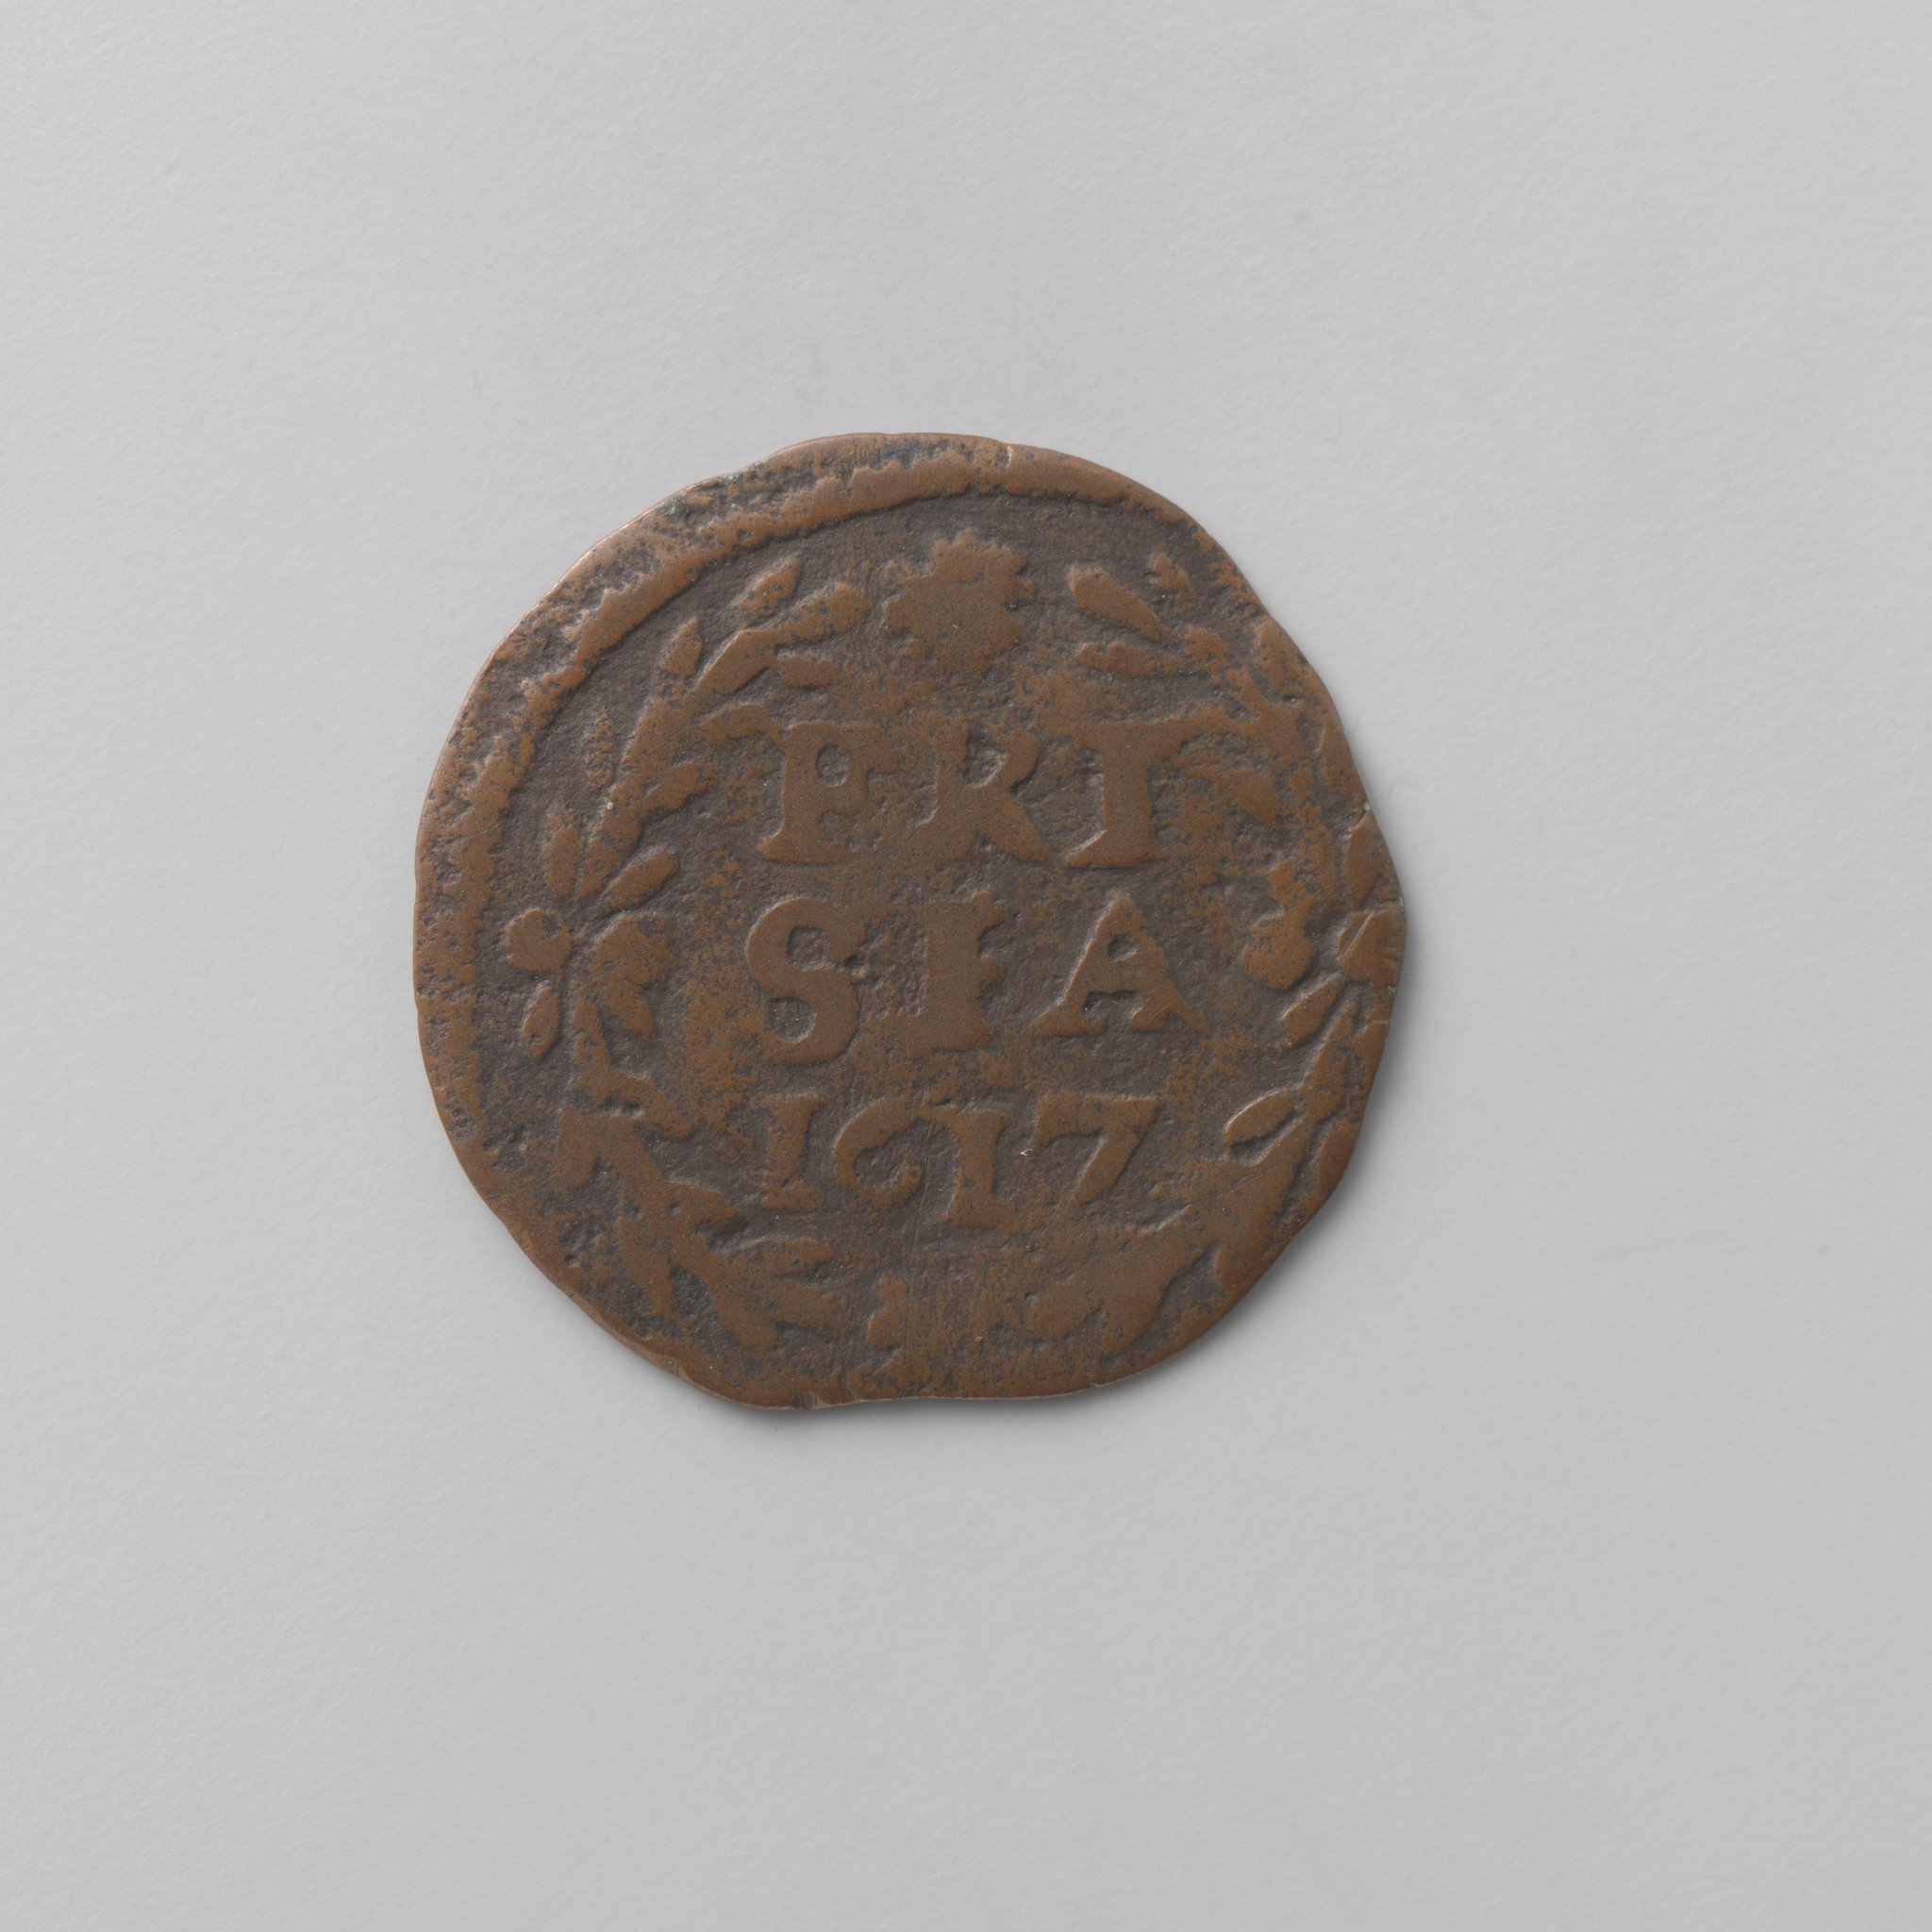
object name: coin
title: Friesland, duit, 1617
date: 1617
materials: copper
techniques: striking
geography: leeuwarden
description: Koperen munt. Voorzijde: gekroond en versierd wapenschild van Friesland. Keerzijde: in een bladerkrans opschrift in twee regels, waaronder jaartal.